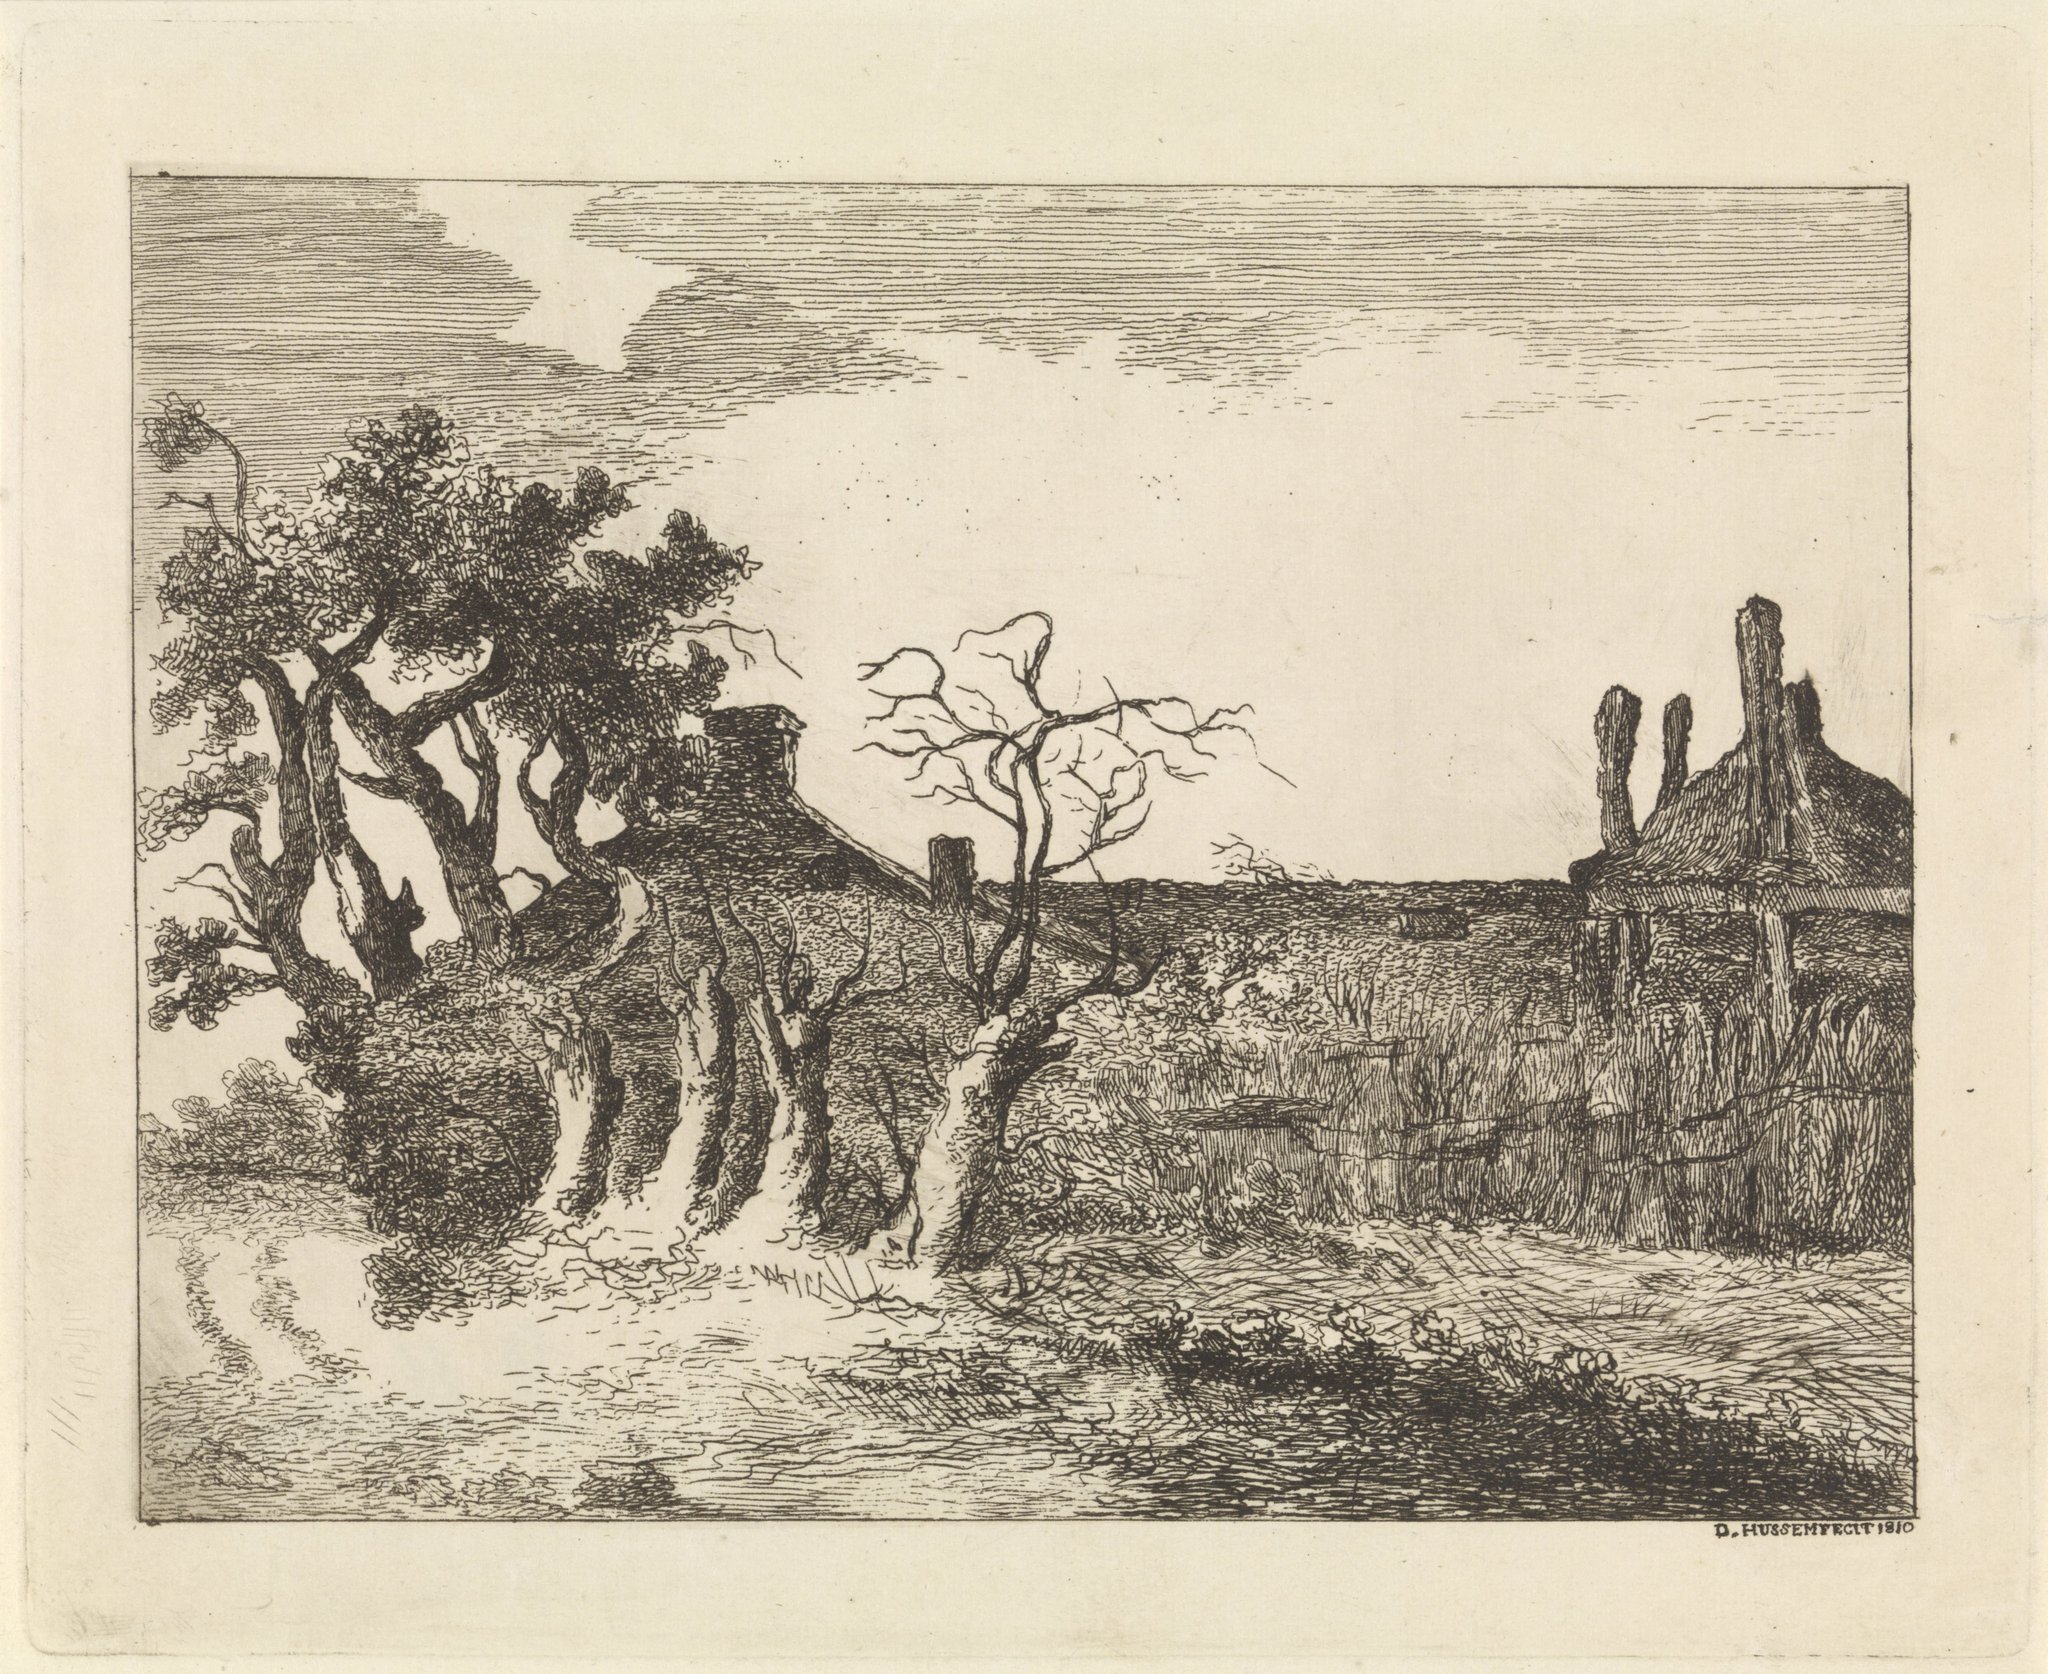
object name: print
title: Wilgen bij boerderij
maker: dirk hussem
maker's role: print maker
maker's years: 1772-1817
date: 1810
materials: paper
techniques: etching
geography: amsterdam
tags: hay-stack, trees: willow, farm or solitary house in landscape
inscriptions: collector's mark: Lugt 2228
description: Wilgen waarvan de voorste vier zijn geknot. Daarachter een boerderij met rechts een hooiberg.